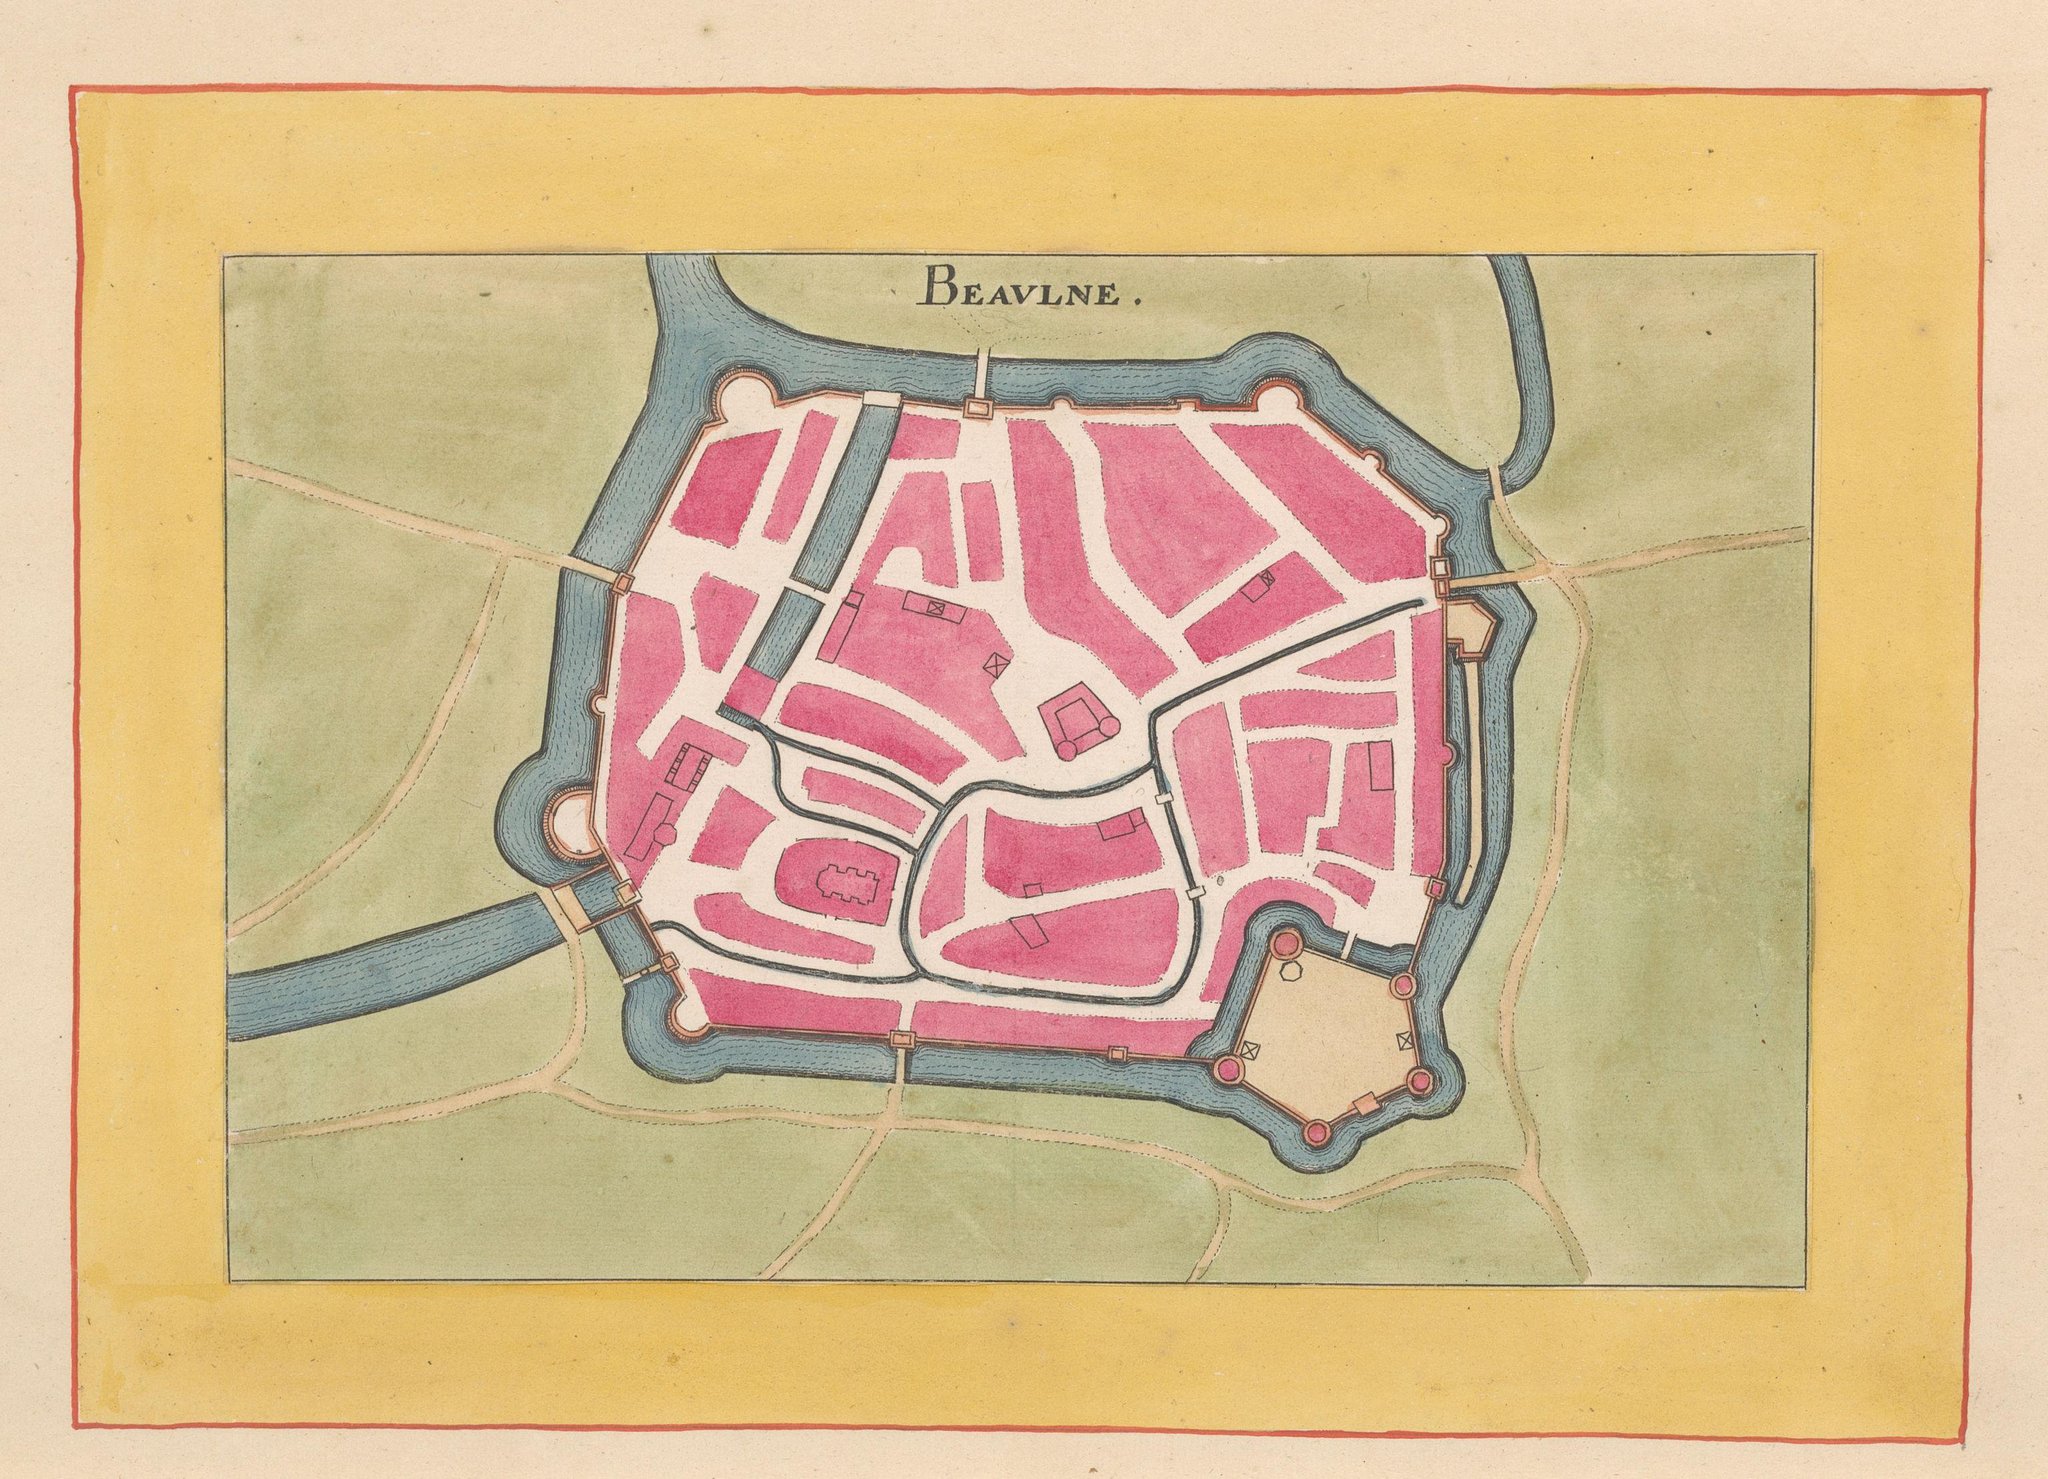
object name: area plan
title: Vestingplattegrond van Beaune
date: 1656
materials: paper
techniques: engraving, etching, hand coloring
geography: the hague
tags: city-view in general; 'veduta'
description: Prent uit: Zeiller, Martin. Topographia Galliae. 13 dln. Frankfurt: Caspar Merian, 1656, dl. 4, na p. 8.